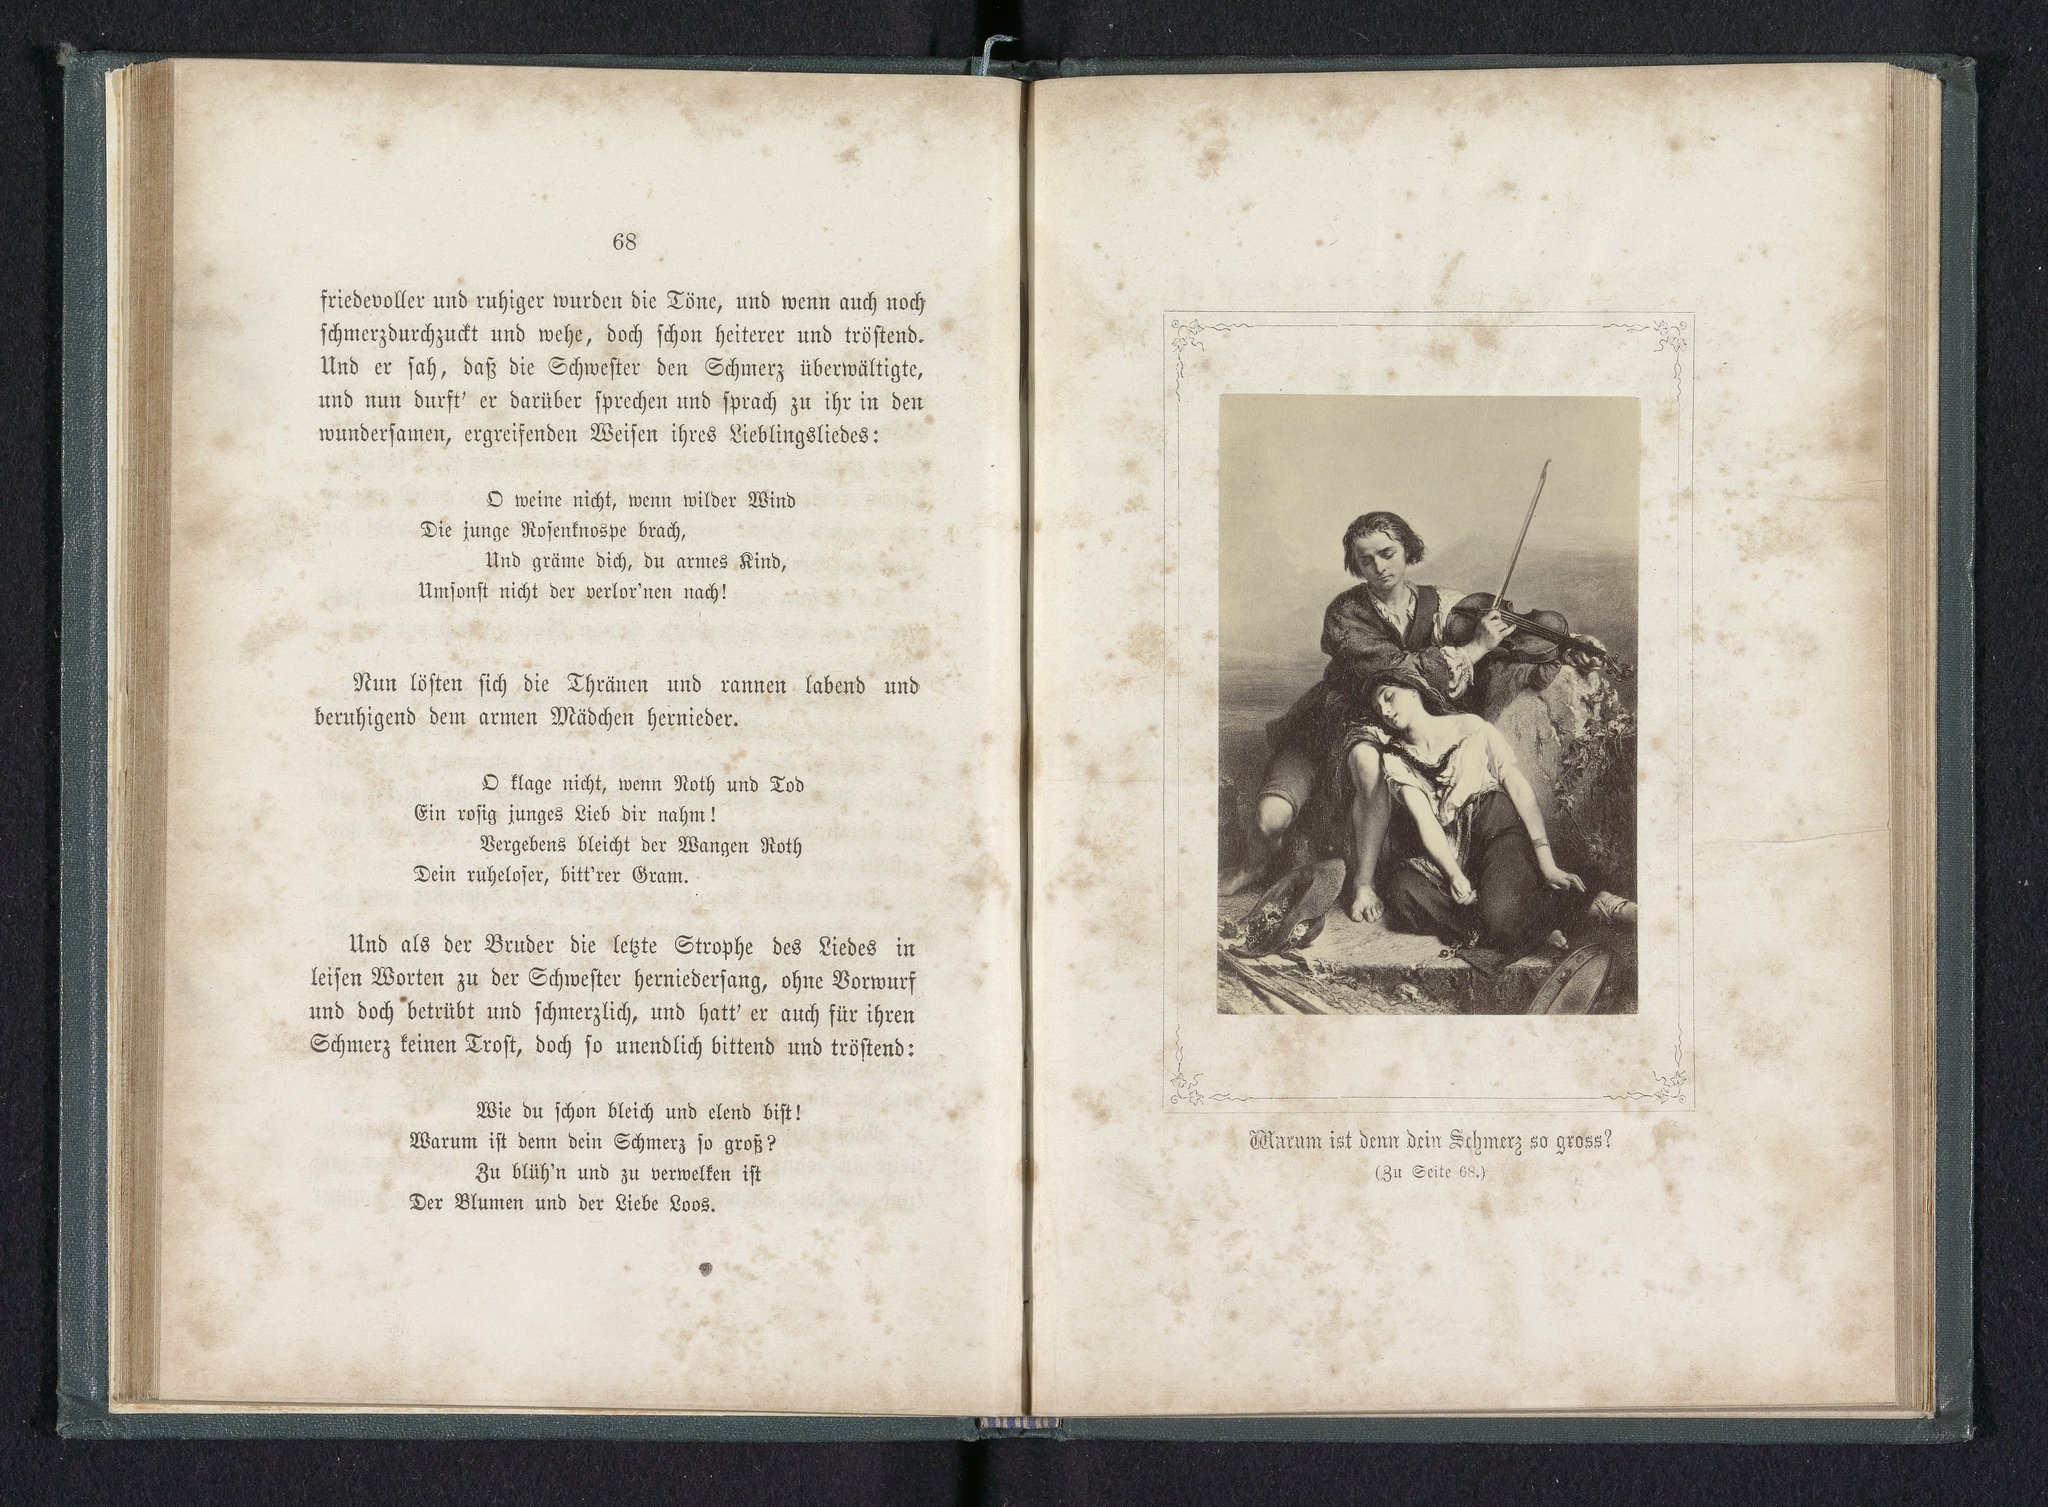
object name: reproduction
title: Warum is denn dein Schmerz so gross?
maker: Anonymous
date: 1852-1862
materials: photographic support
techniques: albumen print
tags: violin, fiddle - cc - out of doors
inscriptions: inscription: ‘(Zu Seite 68.)’